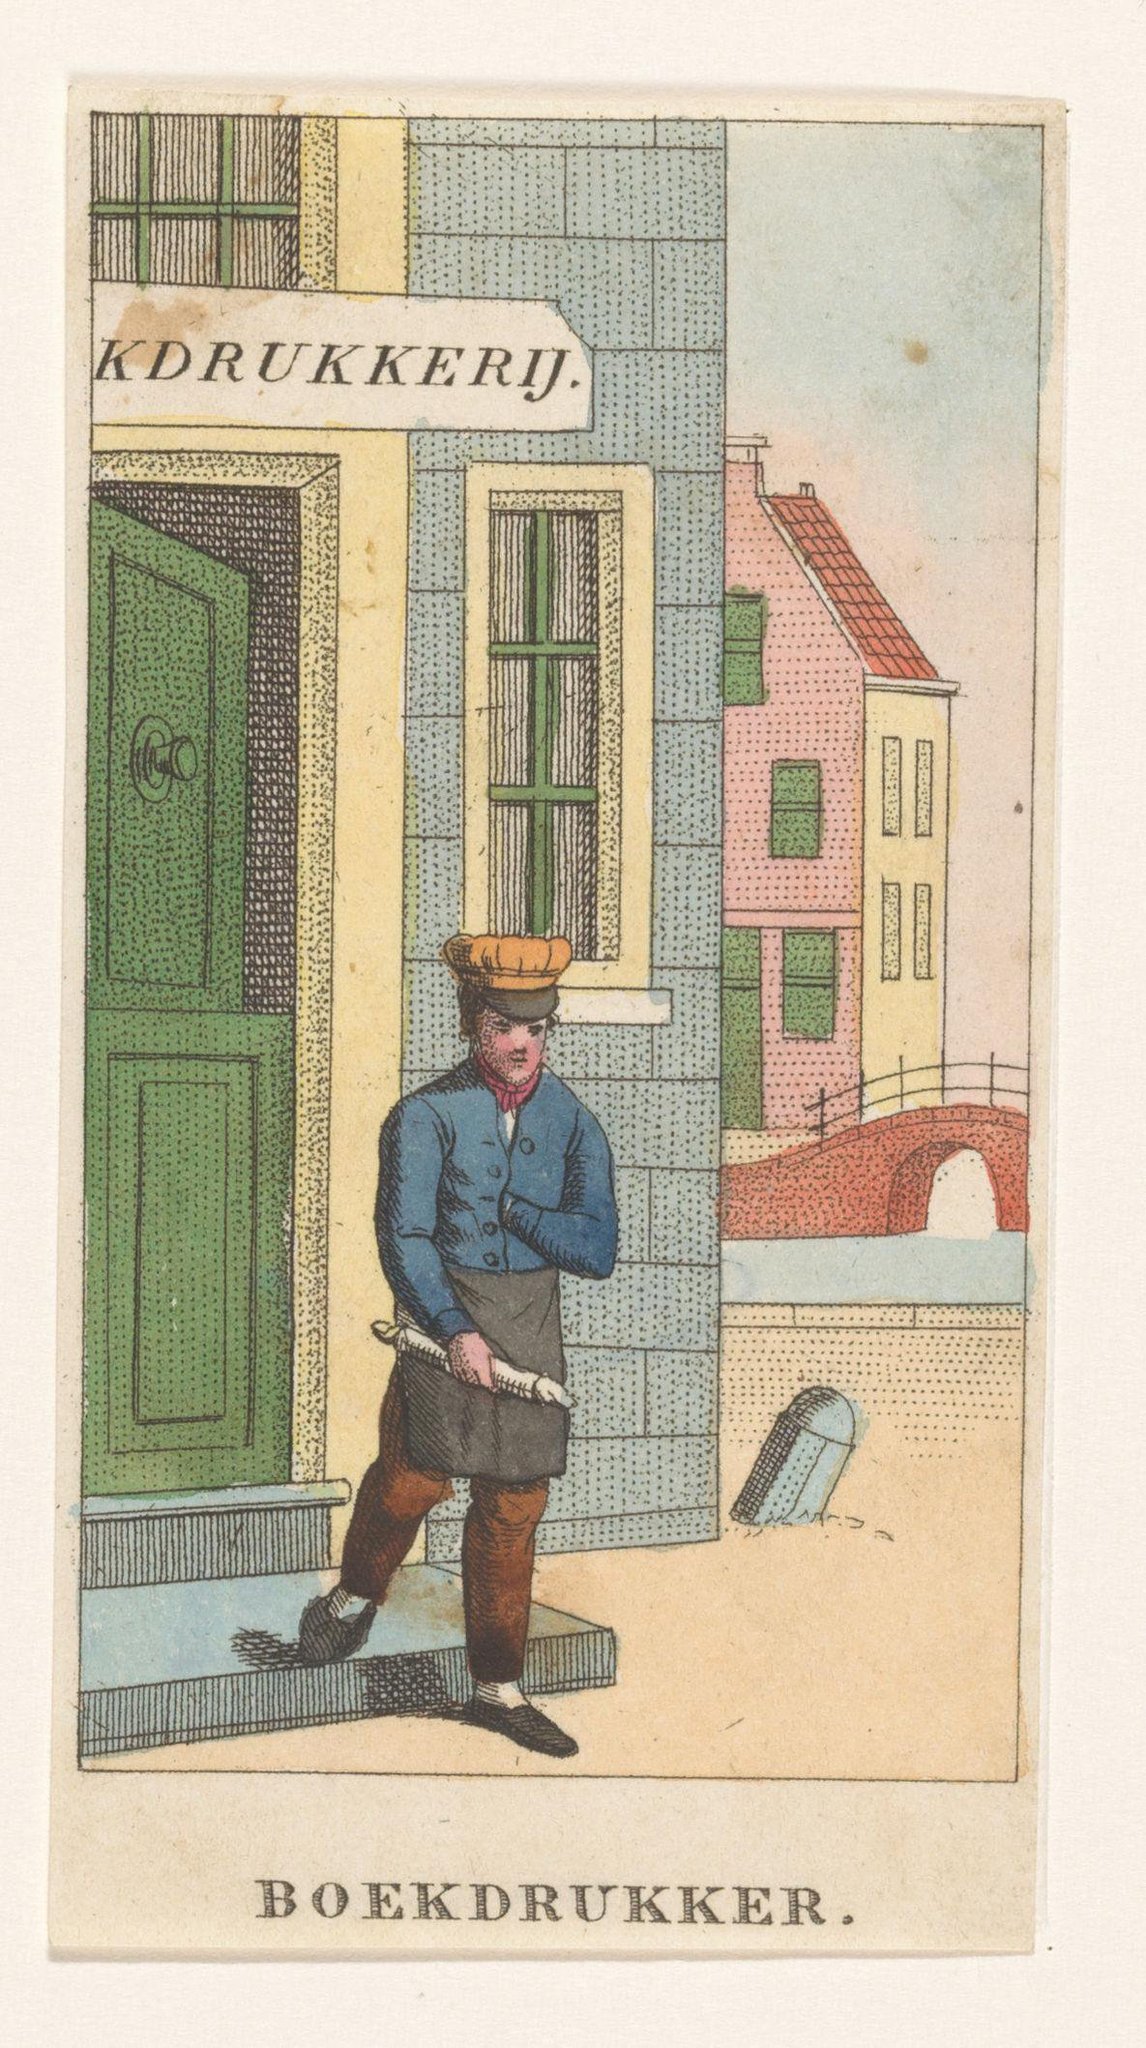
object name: print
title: Jongen voor de gevel van een boekdrukkerij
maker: Anonymous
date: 1800-1899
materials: paper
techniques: etching, hand coloring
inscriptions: collector's mark: Lugt 2228, collector's mark: Lugt 4779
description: Waarschijnlijk afkomstig uit een kinderboek.